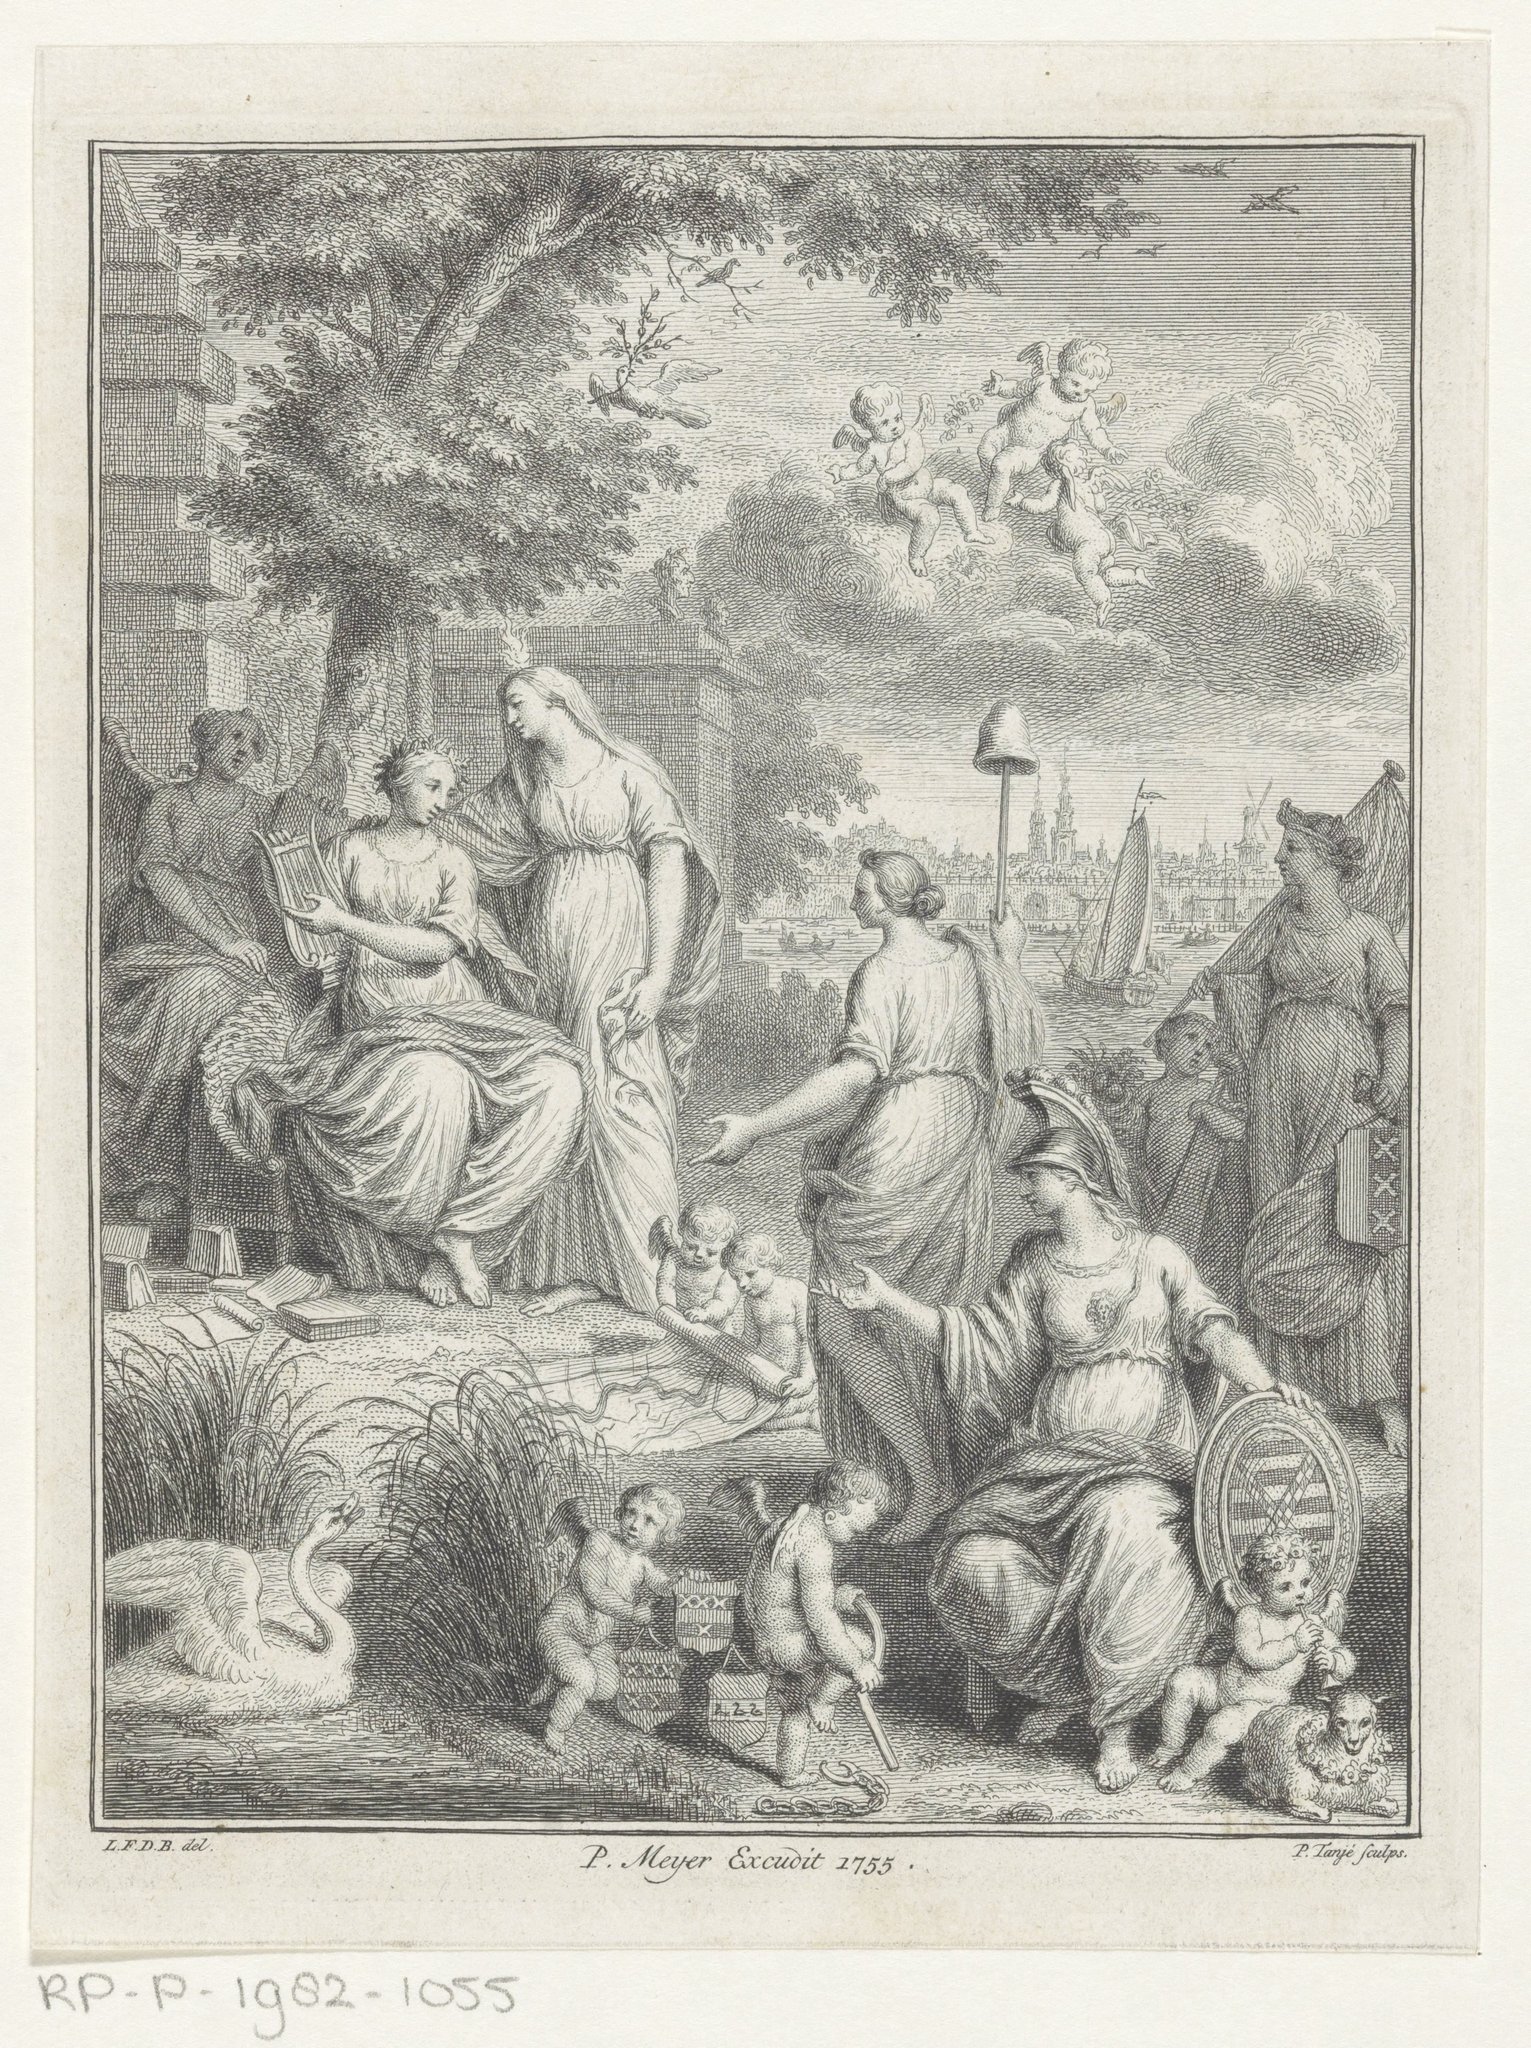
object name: titelblad, titelpagina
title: Dichtkunst en Vrijheid en de rivier de Amstel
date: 1755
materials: paper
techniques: engraving, etching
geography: amsterdam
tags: river, symbolic representations, allegories and emblems ~ poetry; 'poesia' (ripa), freedom, liberty; 'libertà' (ripa), amsterdam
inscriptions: collector's mark: Lugt 2760, collector's mark: Lugt 2228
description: De Vrijheid, met een vrijheidslans, presenteert zich aan de Dichtkunst. Dichtkunst houdt een lier in de handen en wordt bijgestaan door Geschiedenis, met pen, en Godsdienst, die de vlam van goddelijke inspiratie op haar hoofd heeft. Minerva zit op de voorgrond. Putti tonen een kaart met de stroom van de rivier de Amstel. Op de voorgrond tonen putti de wapenschilden van dorpen aan de Amstel. Op de achtergrond de stad Amsterdam met het IJ.